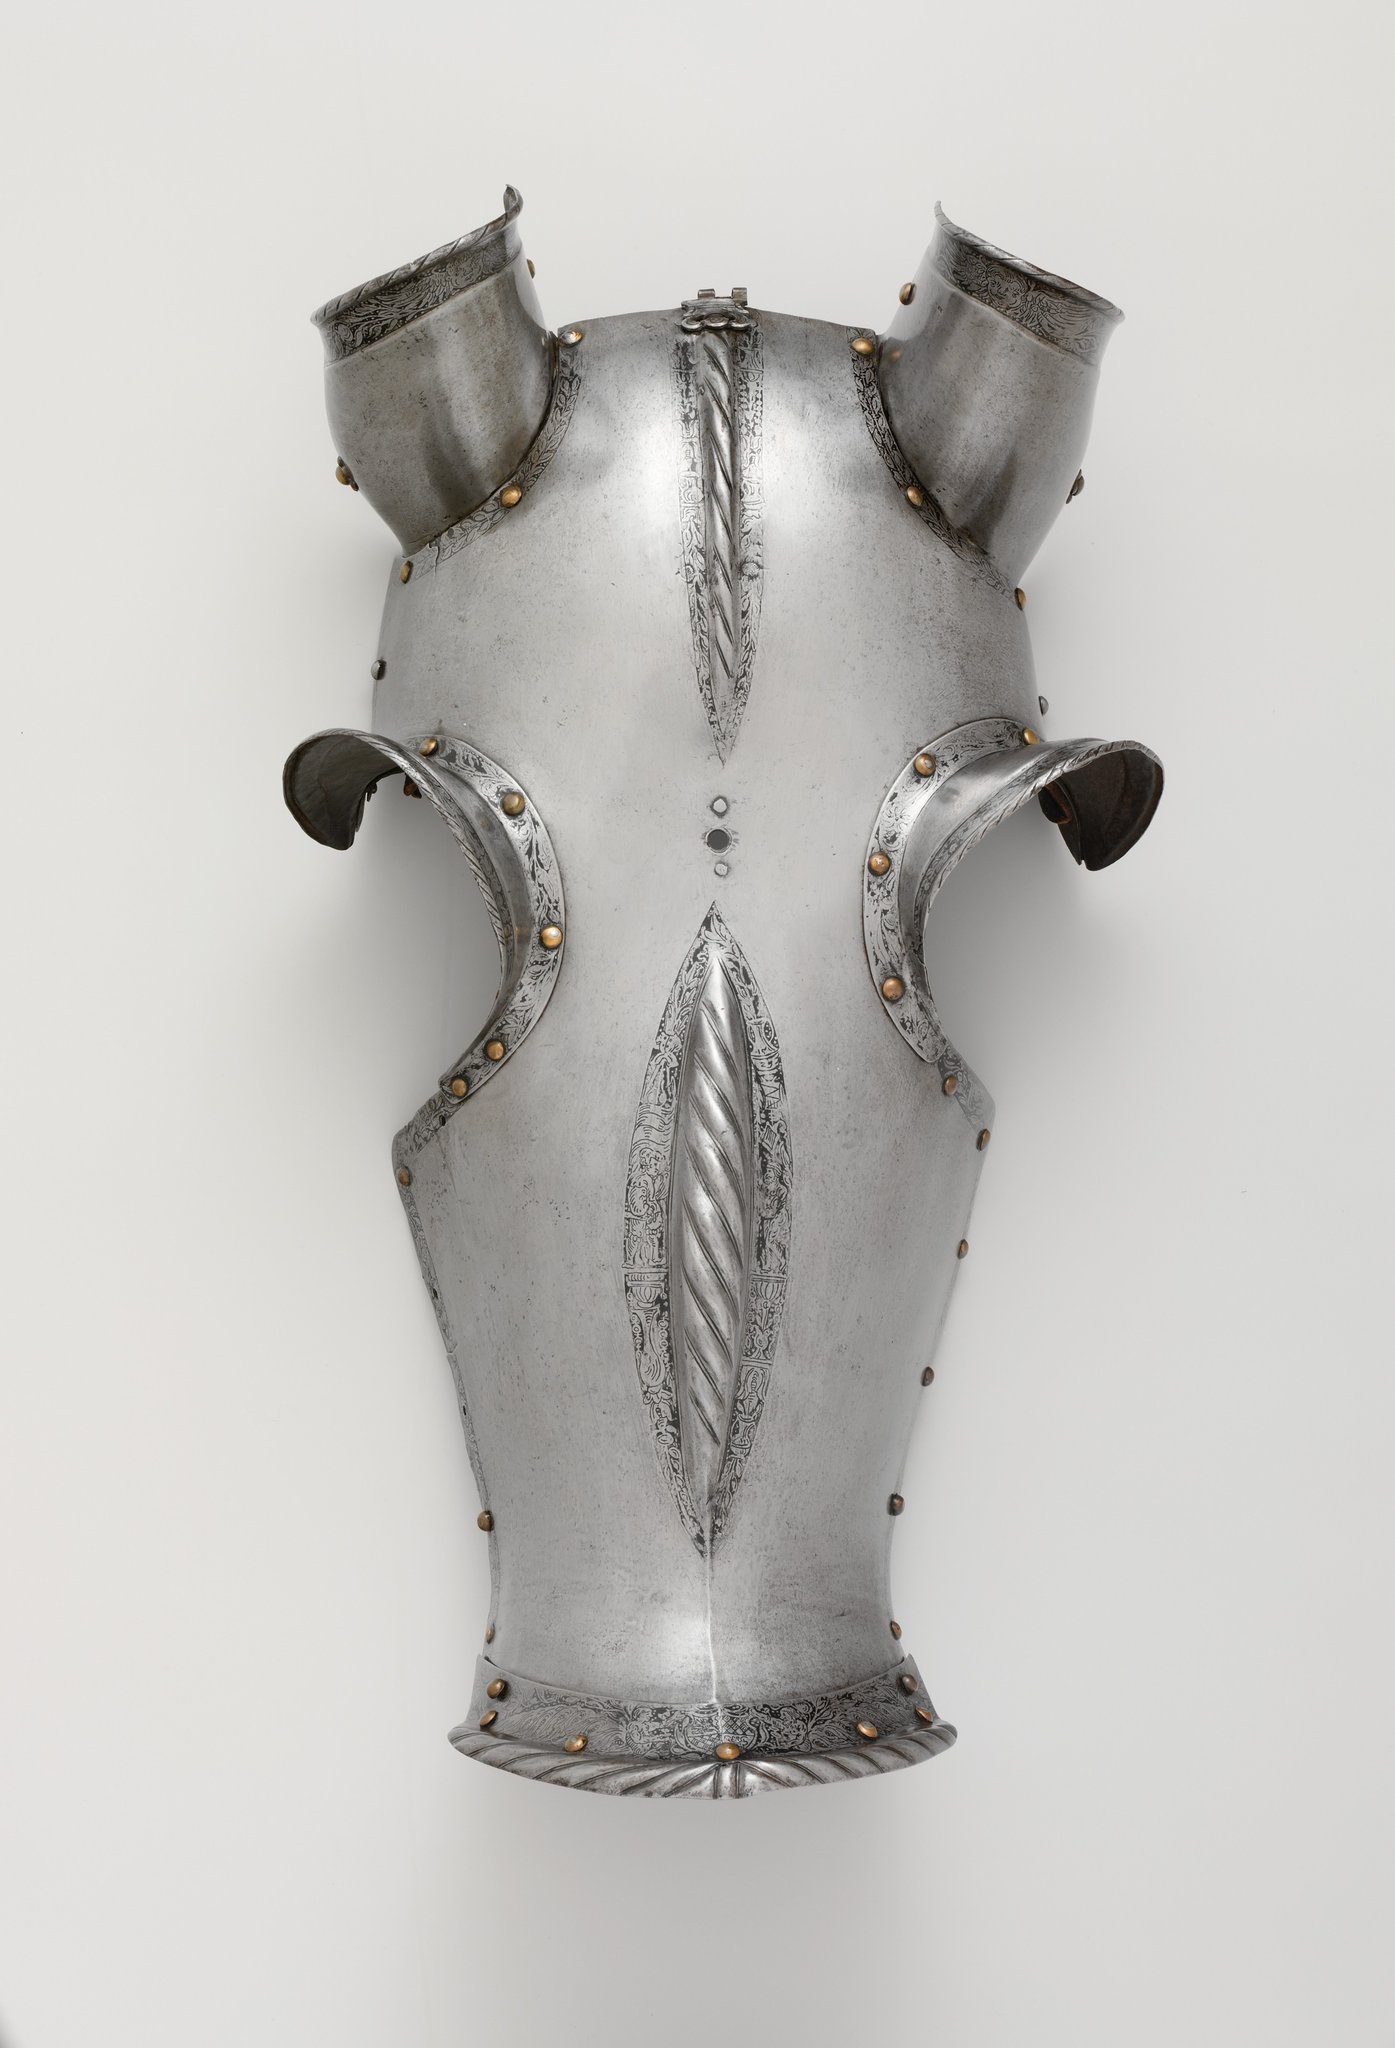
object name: shaffron horse's head defense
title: Shaffron (Horse's Head Defense) of Ottheinrich, Count Palatine of the Rhine (1502–1559)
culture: german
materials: copper alloy, leather, steel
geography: germany